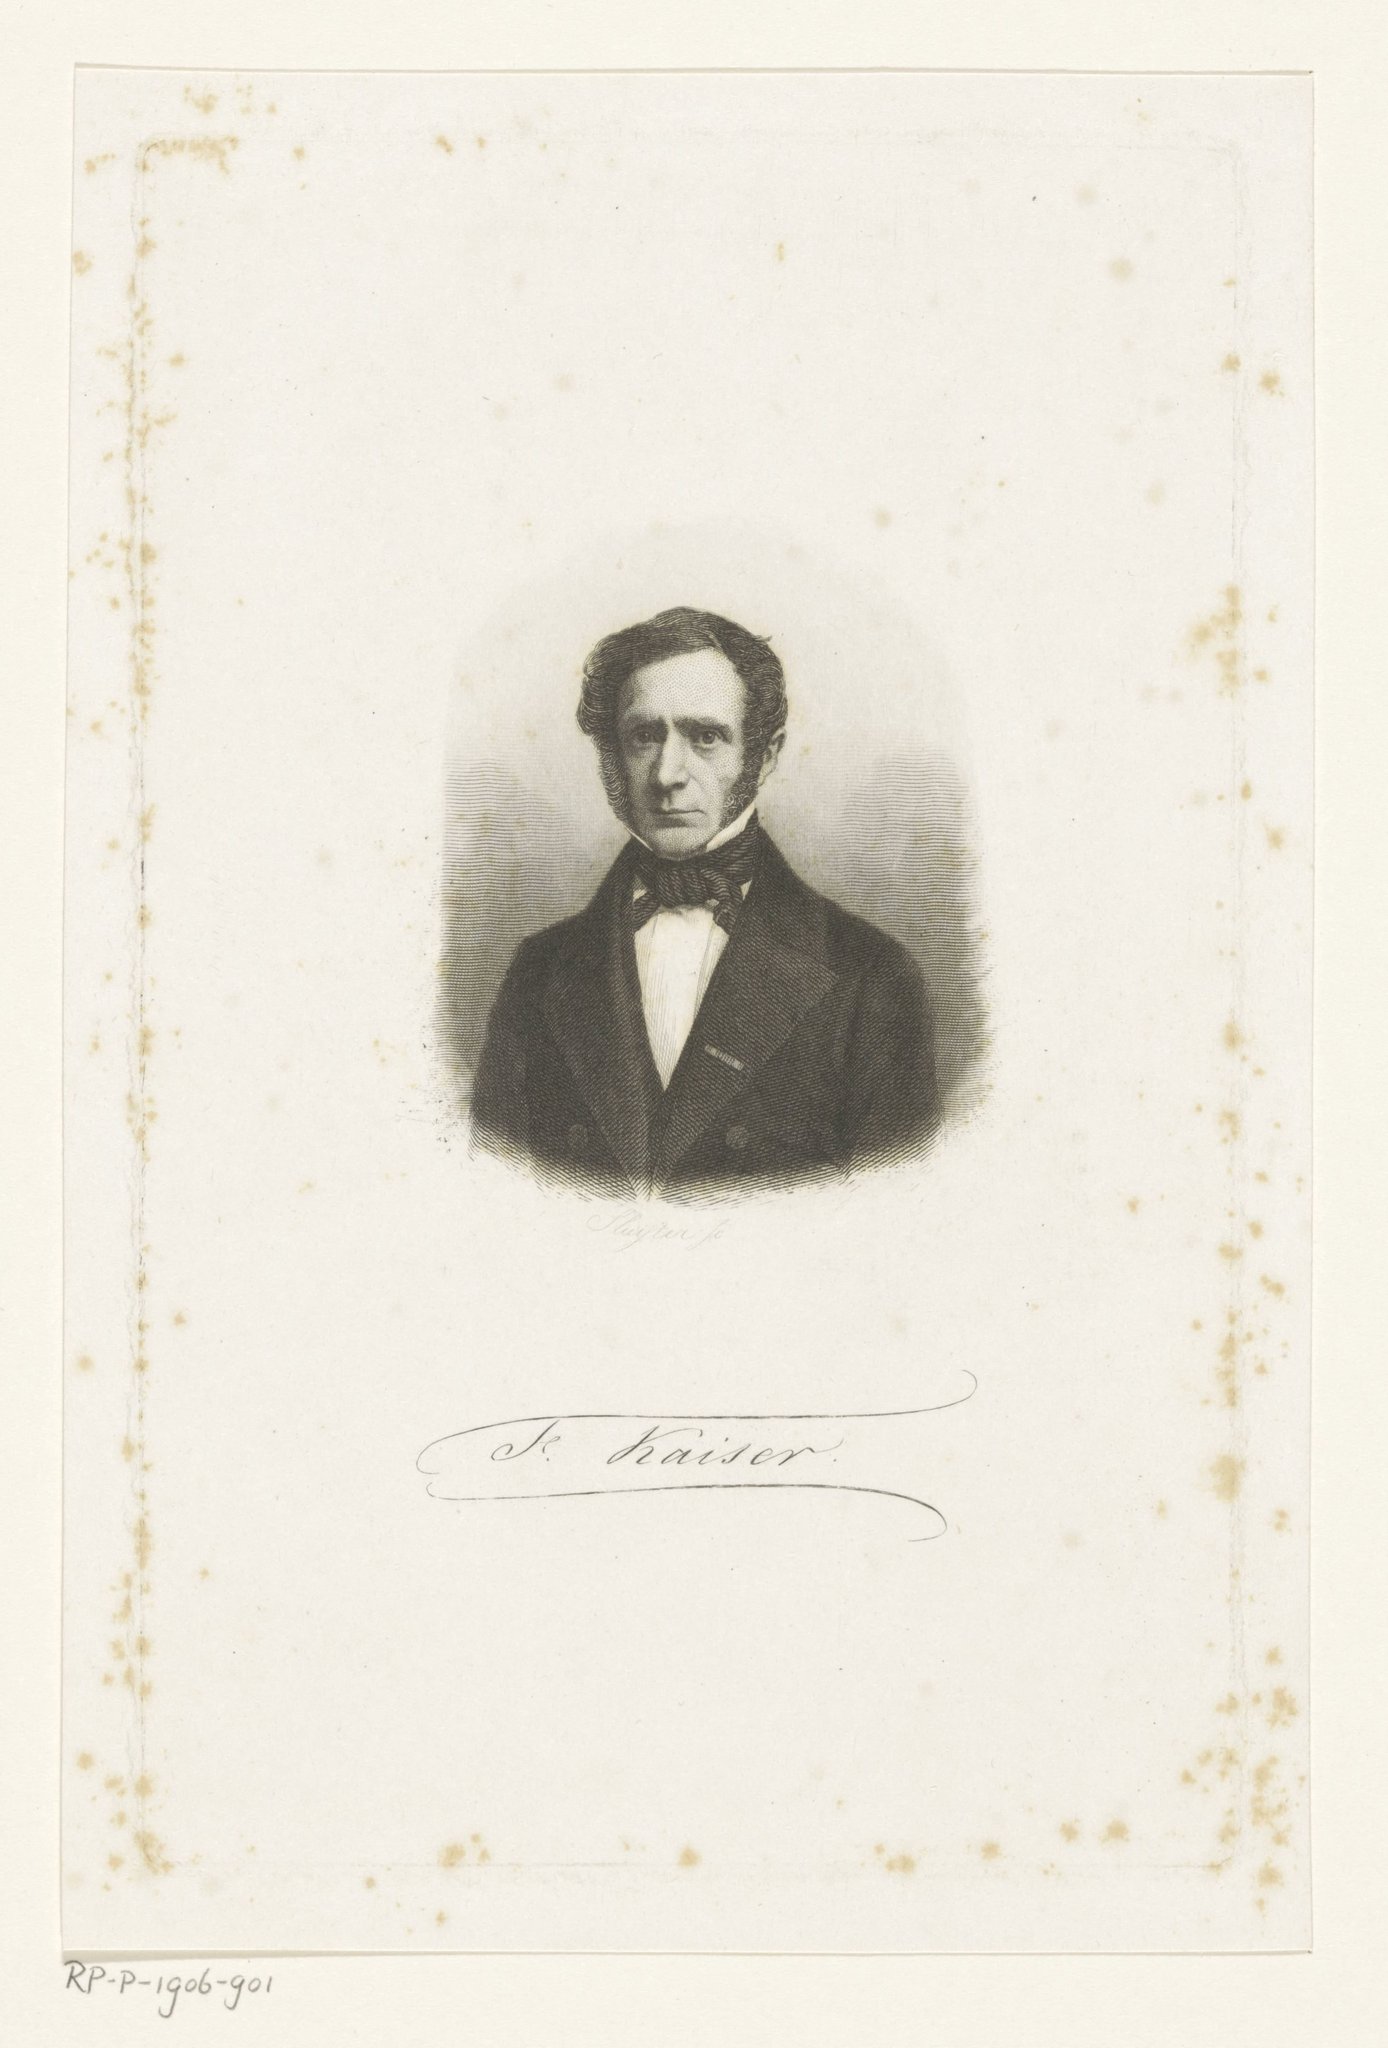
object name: print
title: Portret van de sterrenkundige Frederik Kaiser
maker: dirk jurriaan sluyter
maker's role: draughtsman, print maker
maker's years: 1811-1886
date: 1826-1886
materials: paper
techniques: etching, engraving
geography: amsterdam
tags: frederik kaiser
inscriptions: collector's mark: Lugt 2228